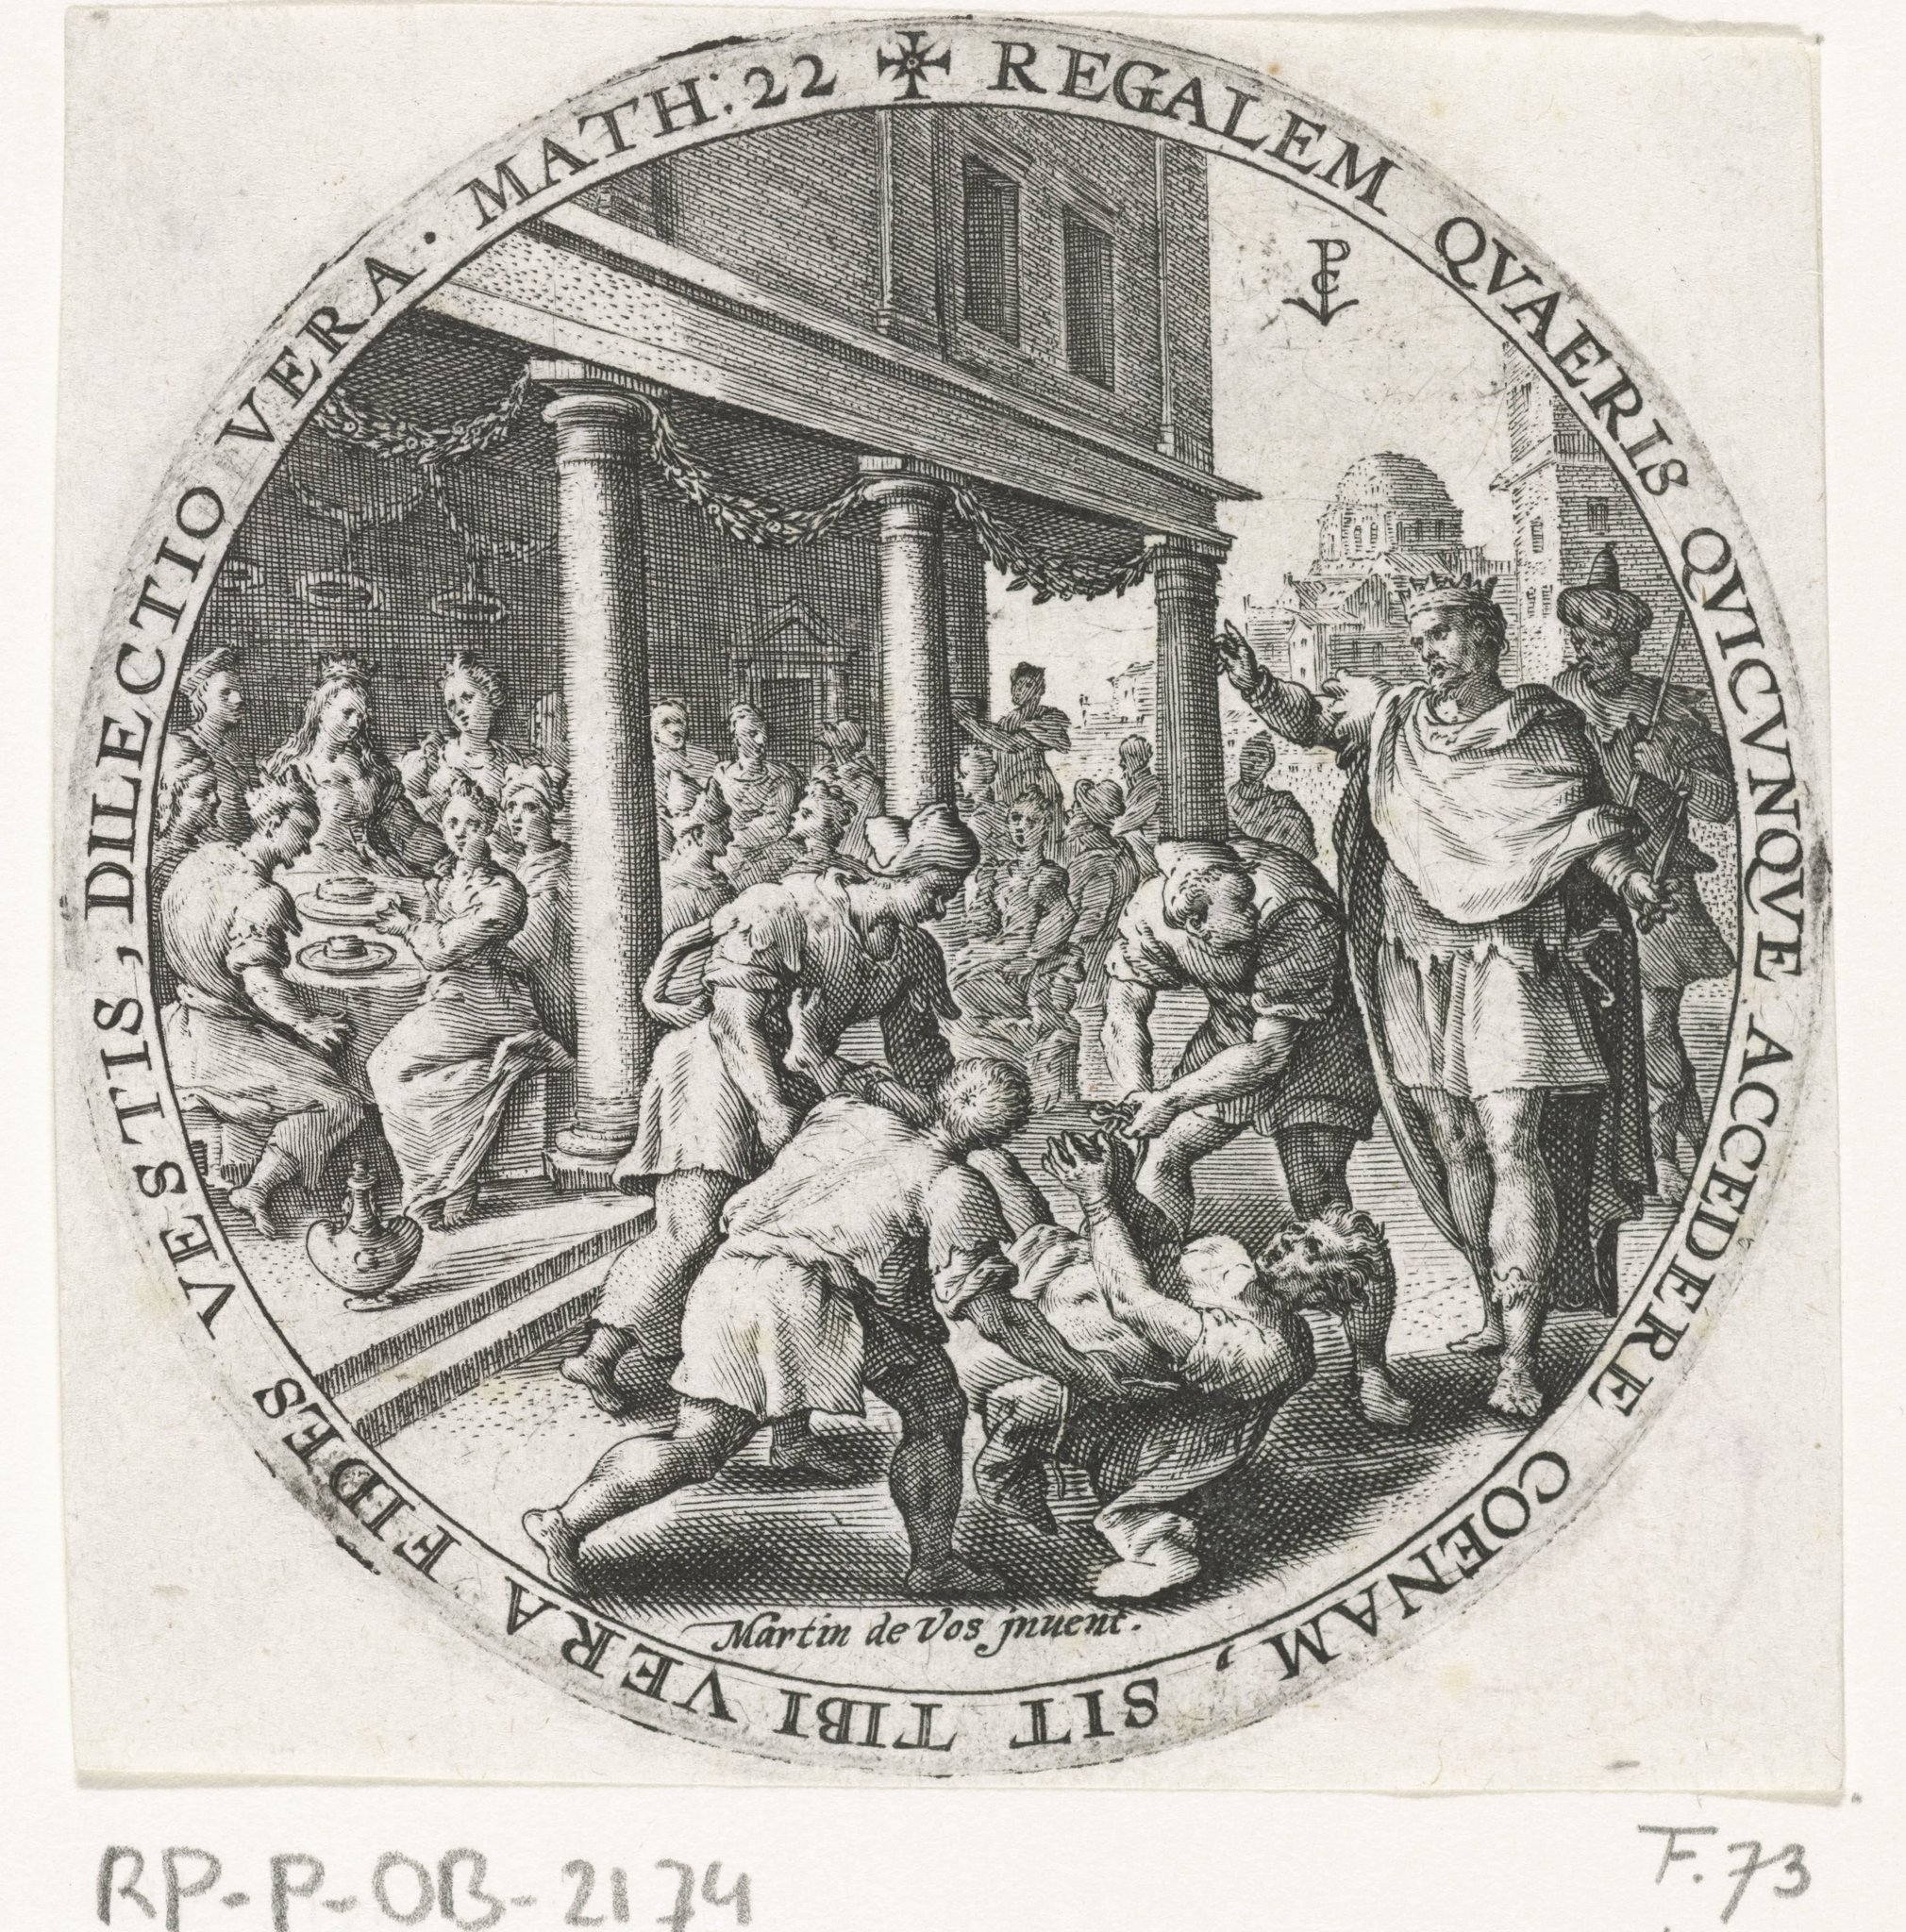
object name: print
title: Gelijkenissen van Christus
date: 1604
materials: paper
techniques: engraving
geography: cologne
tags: the great supper; the royal wedding-feast ~ parable of christ (matthew 22:1-14; luke 14:16-24)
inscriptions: collector's mark: Lugt 240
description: De koning laat de bruiloftsgast die zich niet in bruiloftskleren had gestoken vastbinden en verwijderen. Op de achtergrond zit de bruid met gasten aan tafel (Mat. 22). De voorstelling is gevat in een ronde omlijsting met een randschrift in het Latijn. Prent uit een serie met gelijkenissen van Christus.